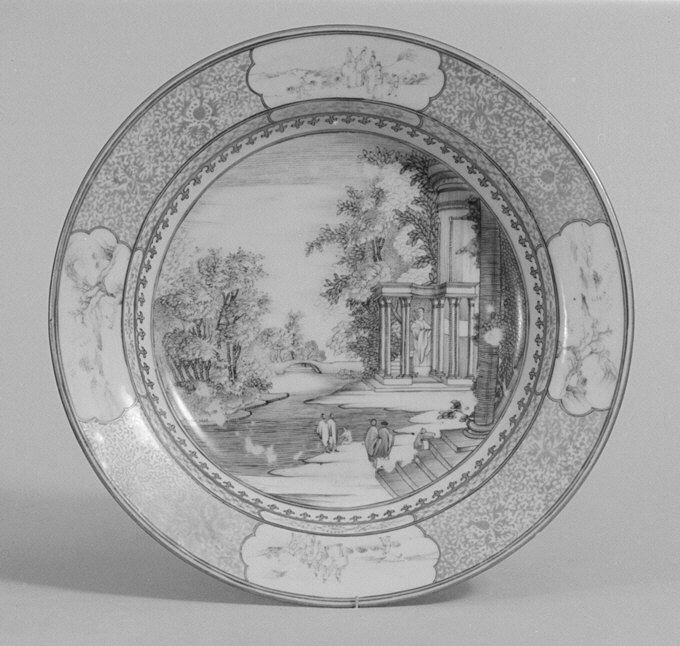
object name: dish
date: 1750-1760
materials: hard paste porcelain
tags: buildings,rivers